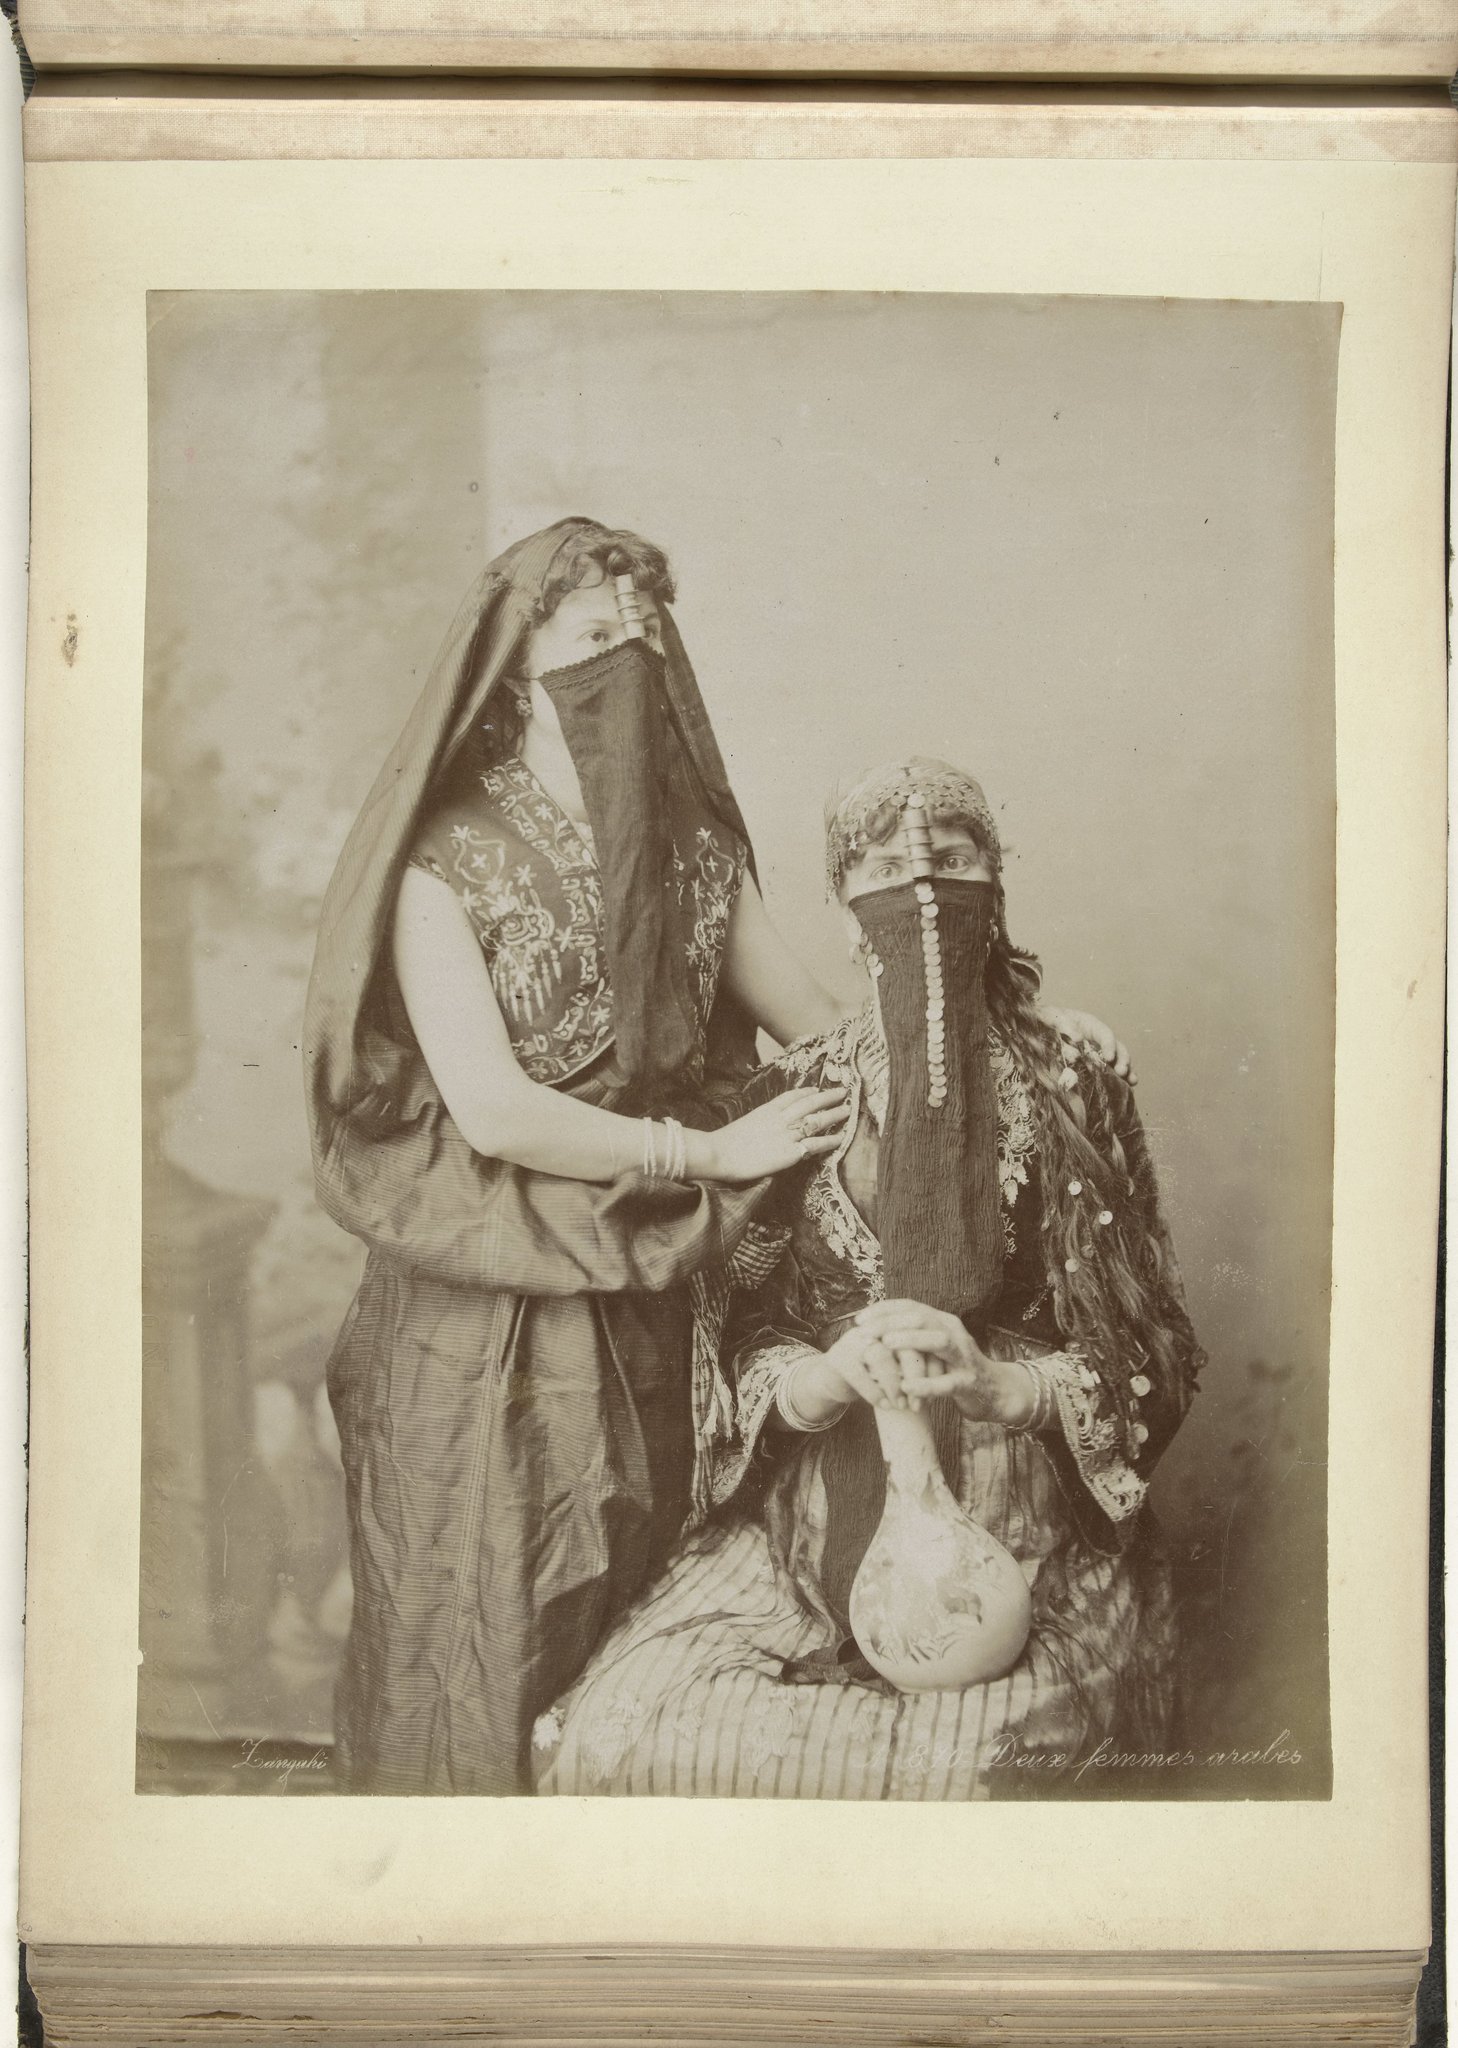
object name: photograph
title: Portret van twee onbekende gesluierde vrouwen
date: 1870-1910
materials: paper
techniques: albumen print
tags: historical persons - bb - woman, container of ceramics: jar, jug, pot, vase, veil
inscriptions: number: ‘No 810.’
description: Zij dragen voor het gezicht, vanaf bovenkant neus, een doek, op schoot heeft een van hen een aardewerken kruik